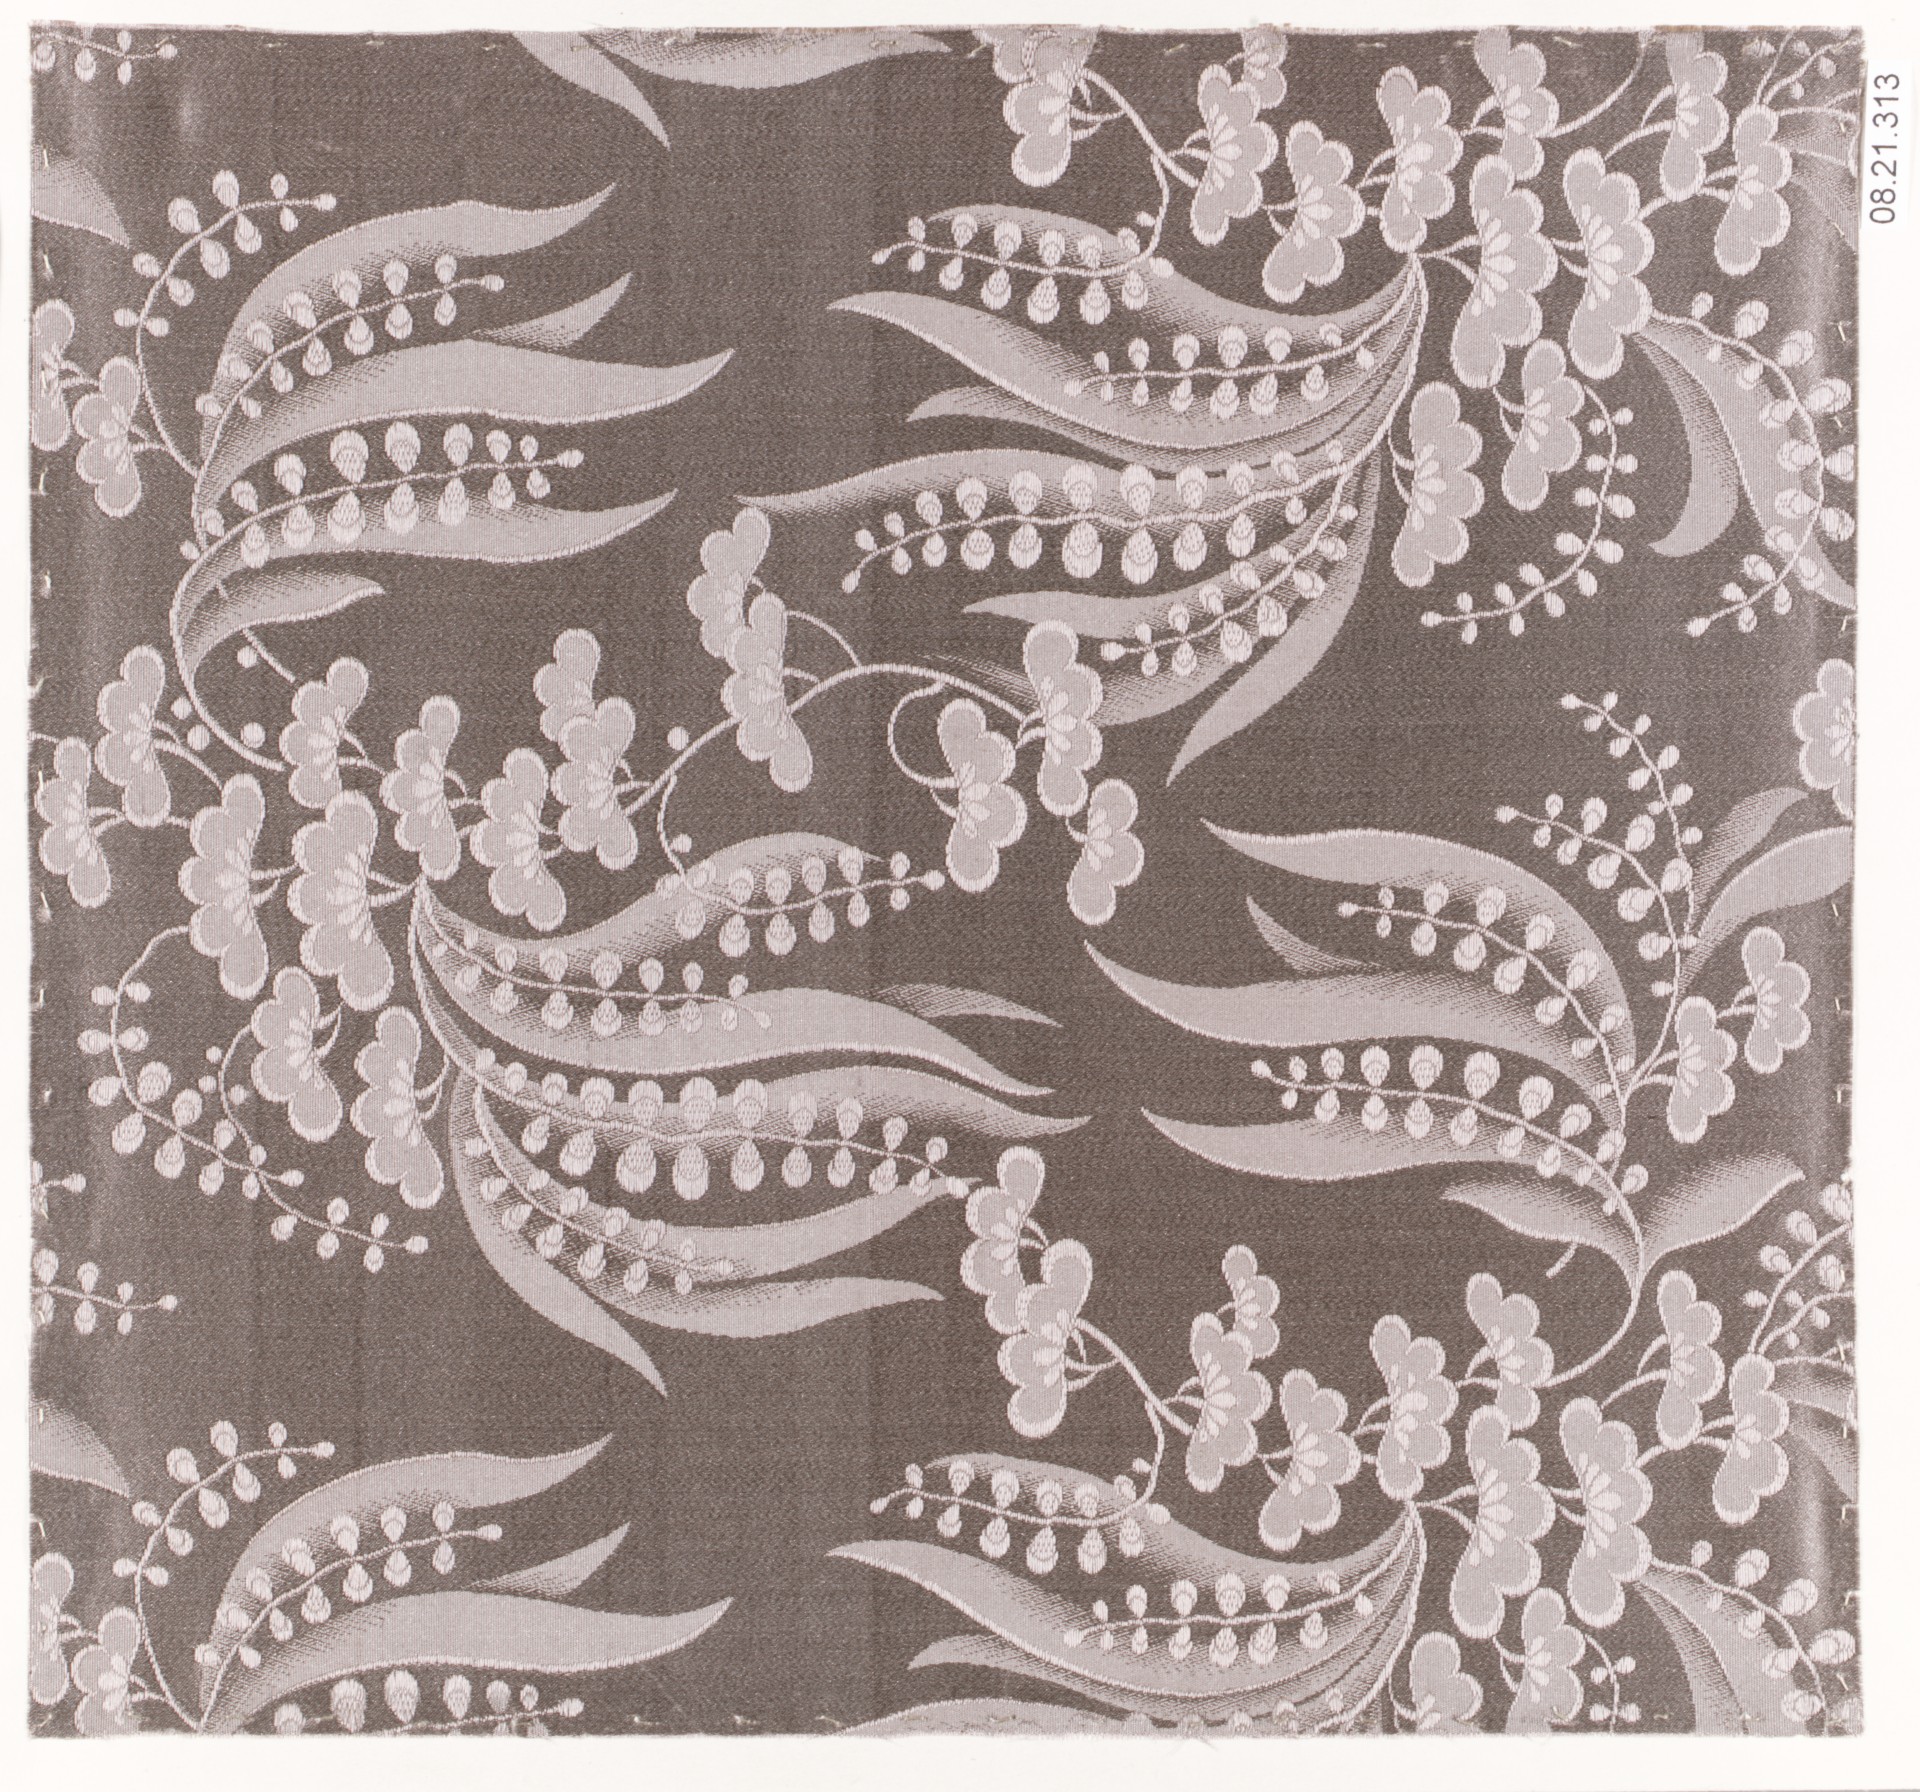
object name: textile sample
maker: Anonymous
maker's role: designer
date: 1900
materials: silk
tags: flowers,leaves